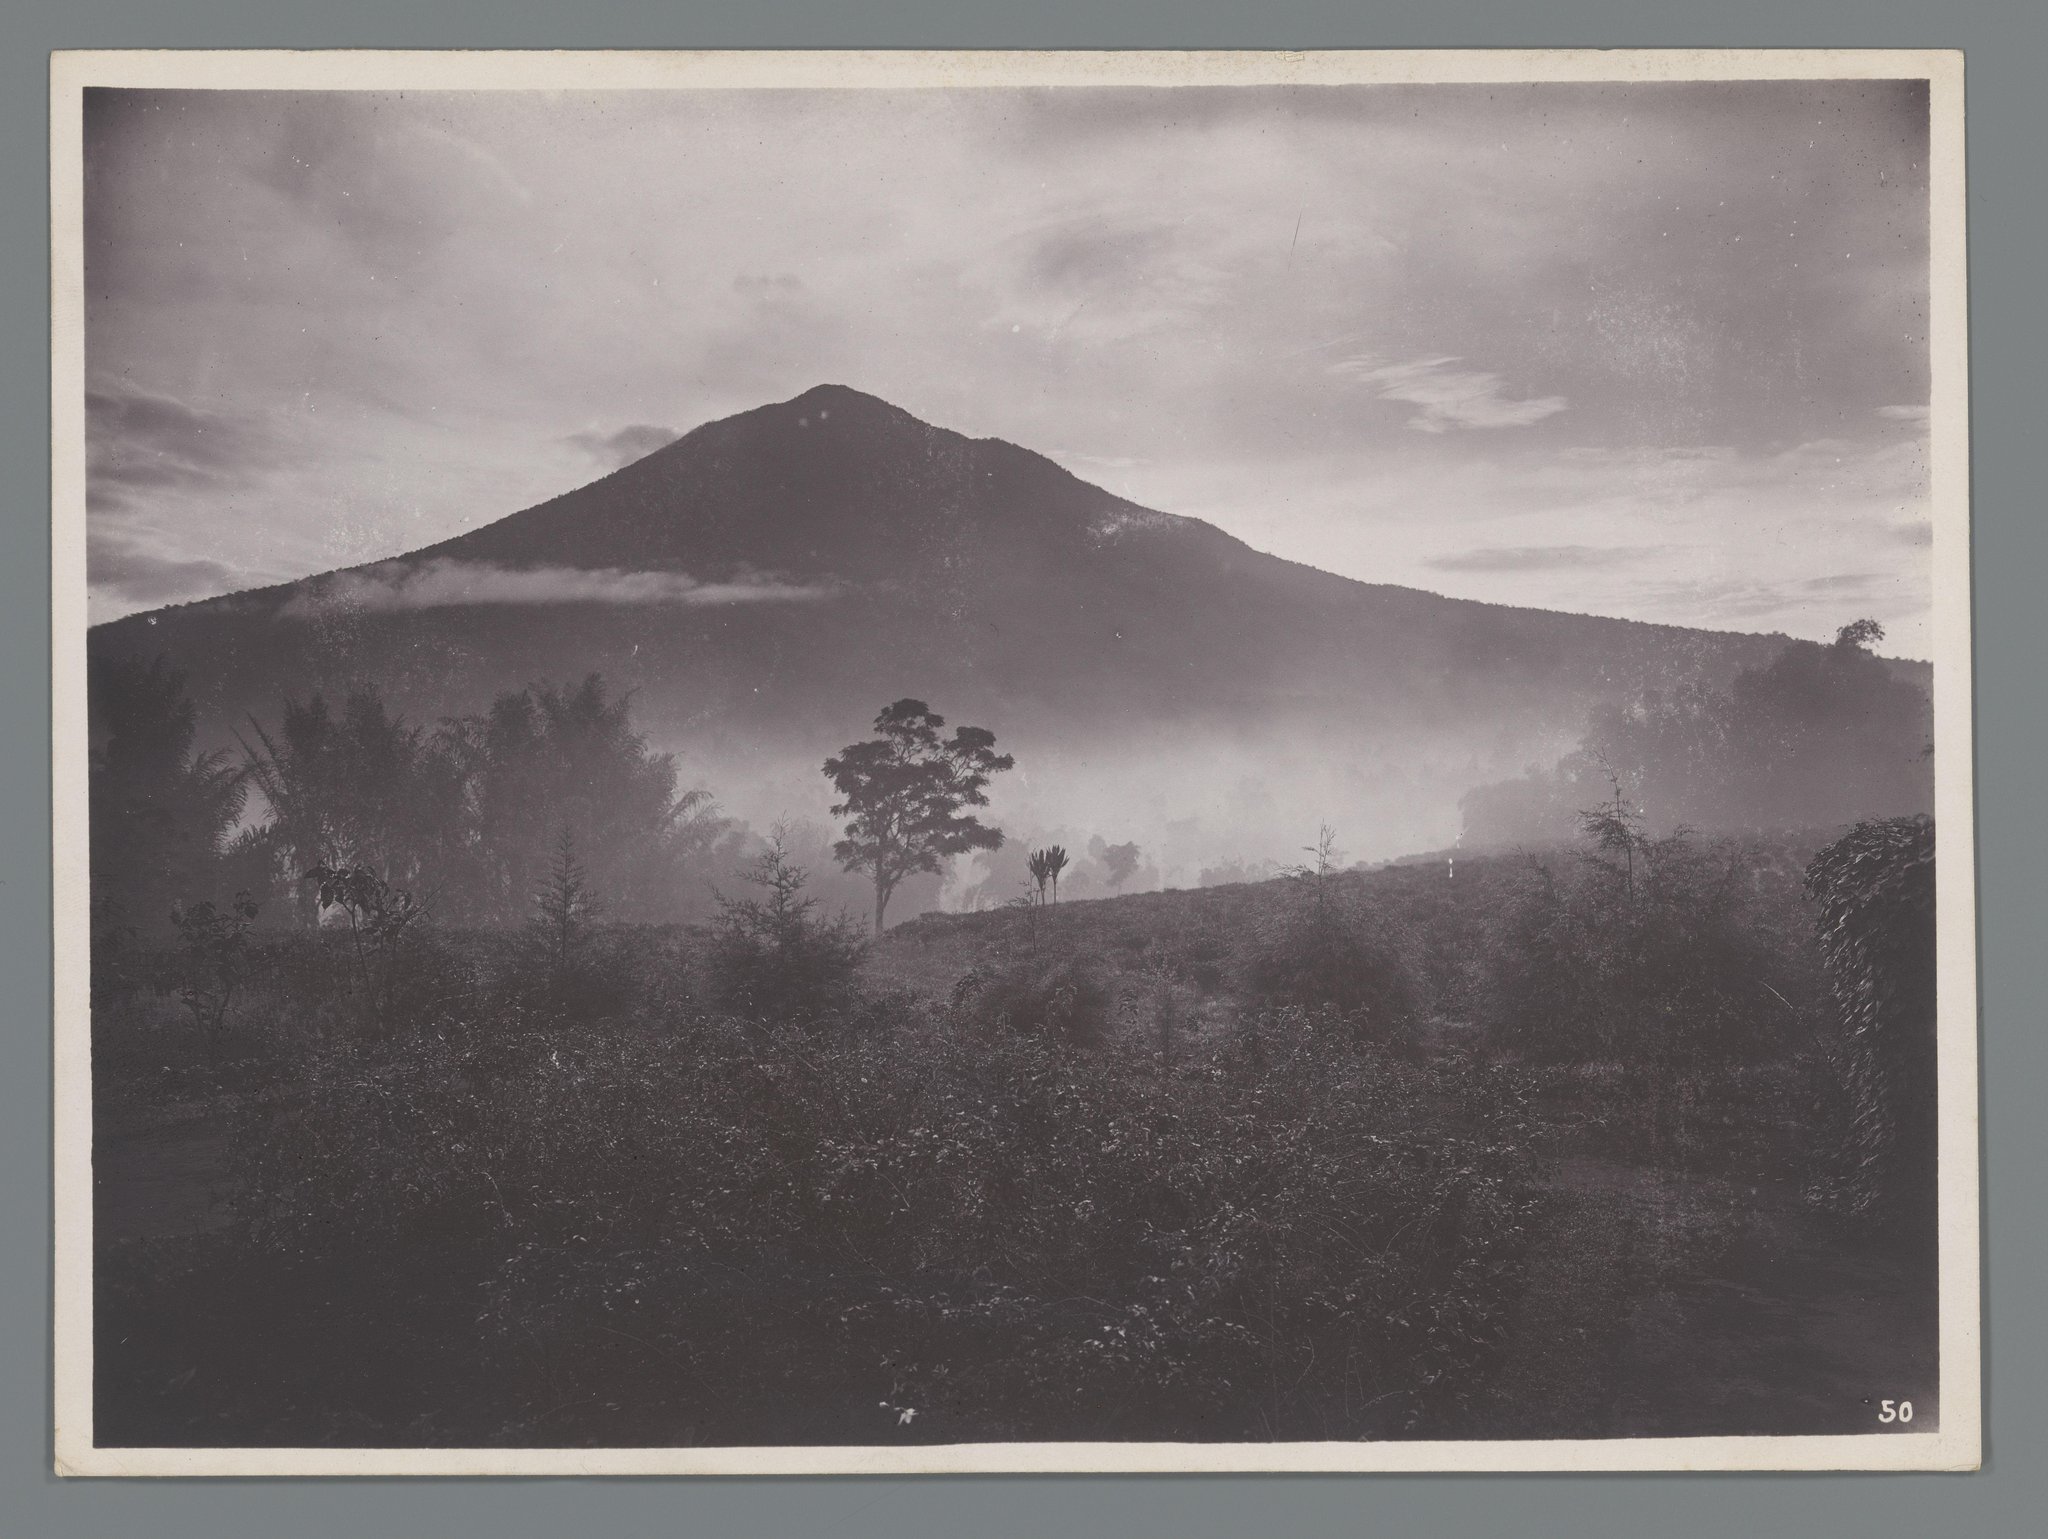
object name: photograph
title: Berglandschap in Indonesië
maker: thilly weissenborn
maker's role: fotograaf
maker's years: 1889-1964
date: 1921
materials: paper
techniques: gelatin silver print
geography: indonesia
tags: mountains, indonesia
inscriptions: number: ‘50’